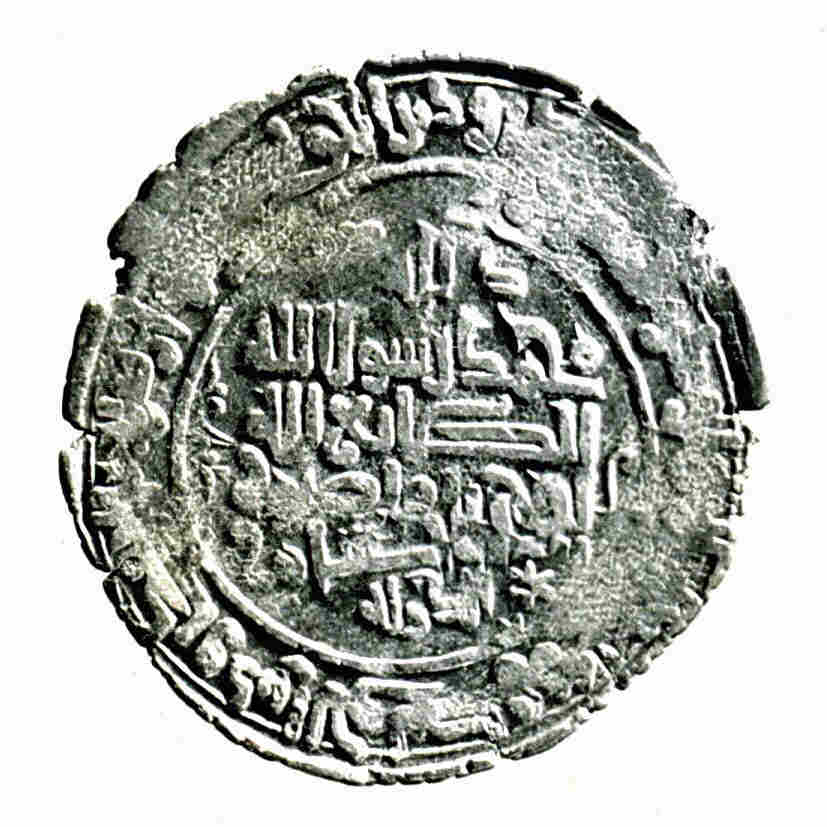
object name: coin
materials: silver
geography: iran